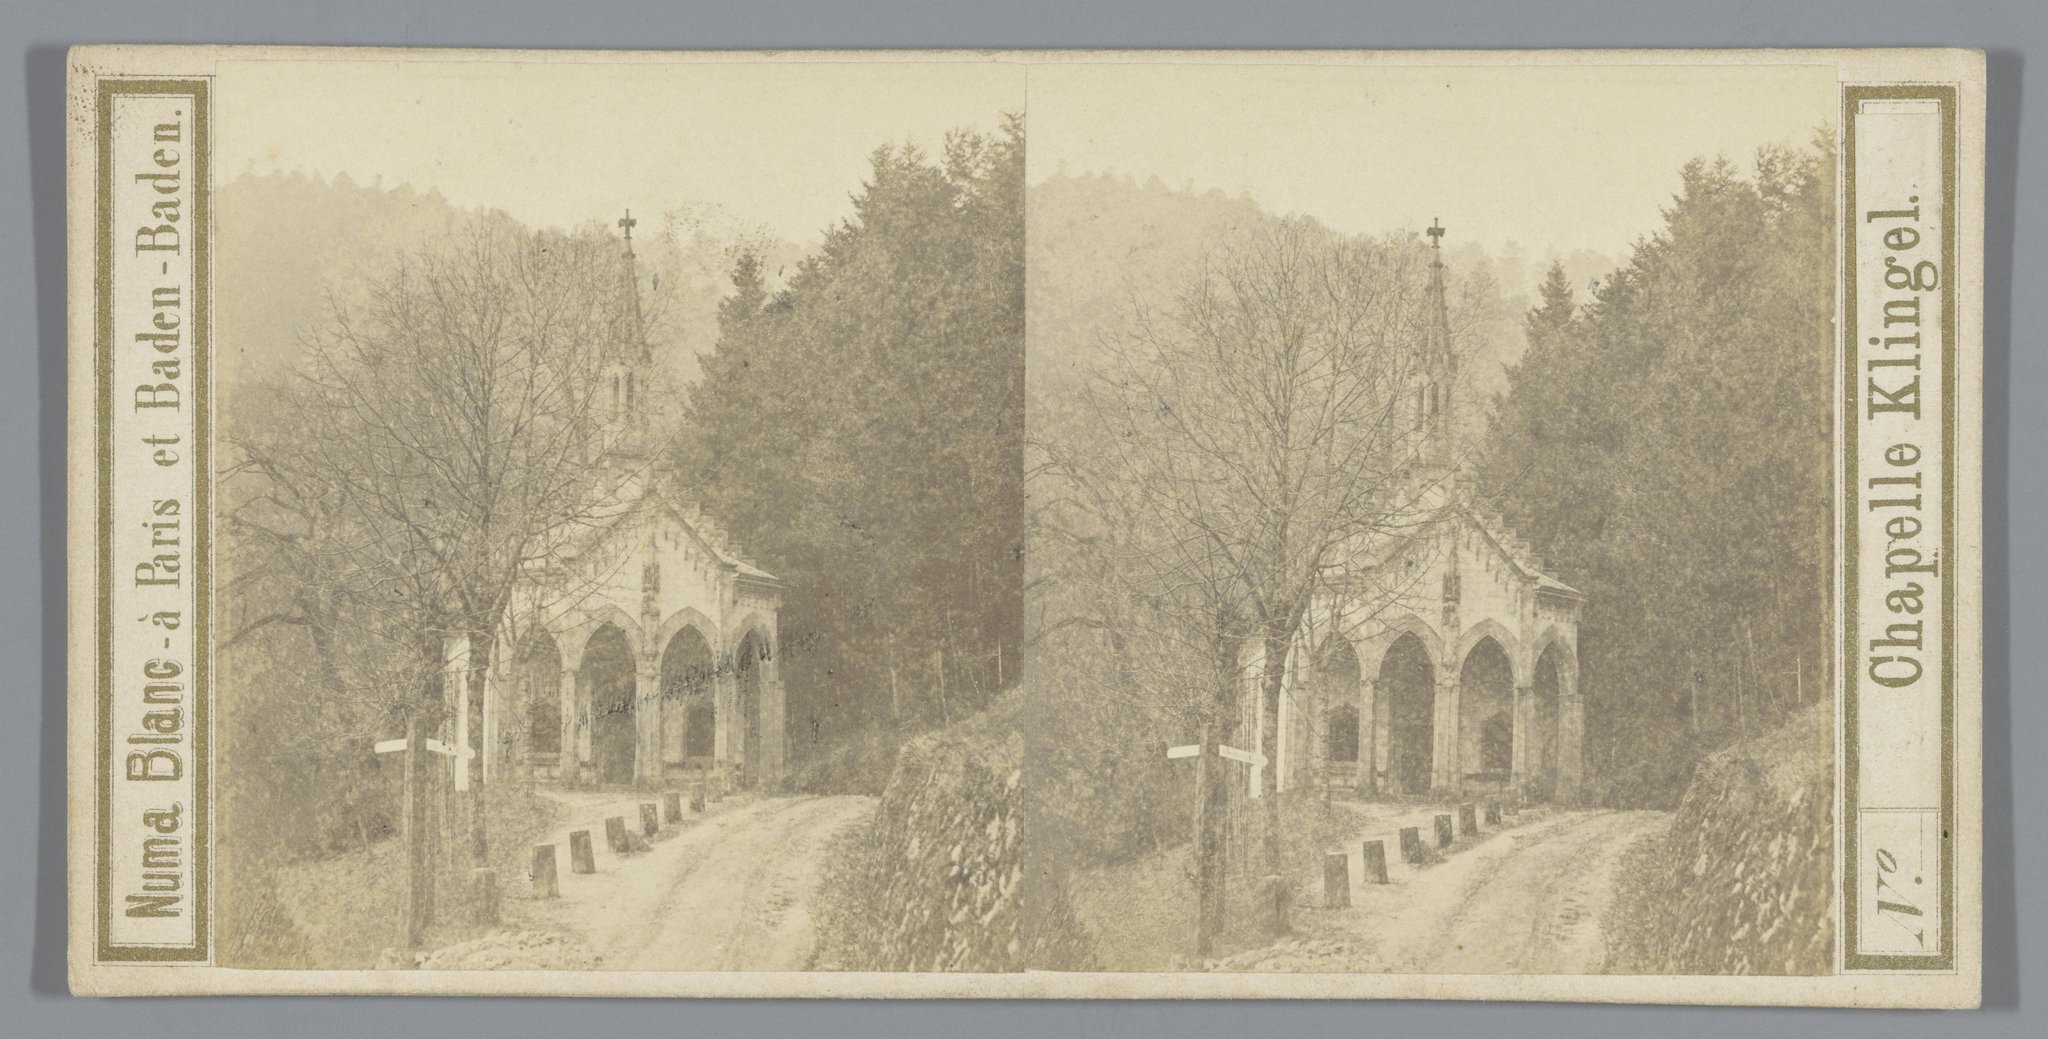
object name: stereograph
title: Exterieur van de Klingelkapelle nabij Gernsbach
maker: numa blanc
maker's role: publisher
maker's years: 1816-1897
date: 1860-1880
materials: cardboard, photographic support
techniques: albumen print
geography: baden-württemberg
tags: church (exterior) - qq - small church, chapel